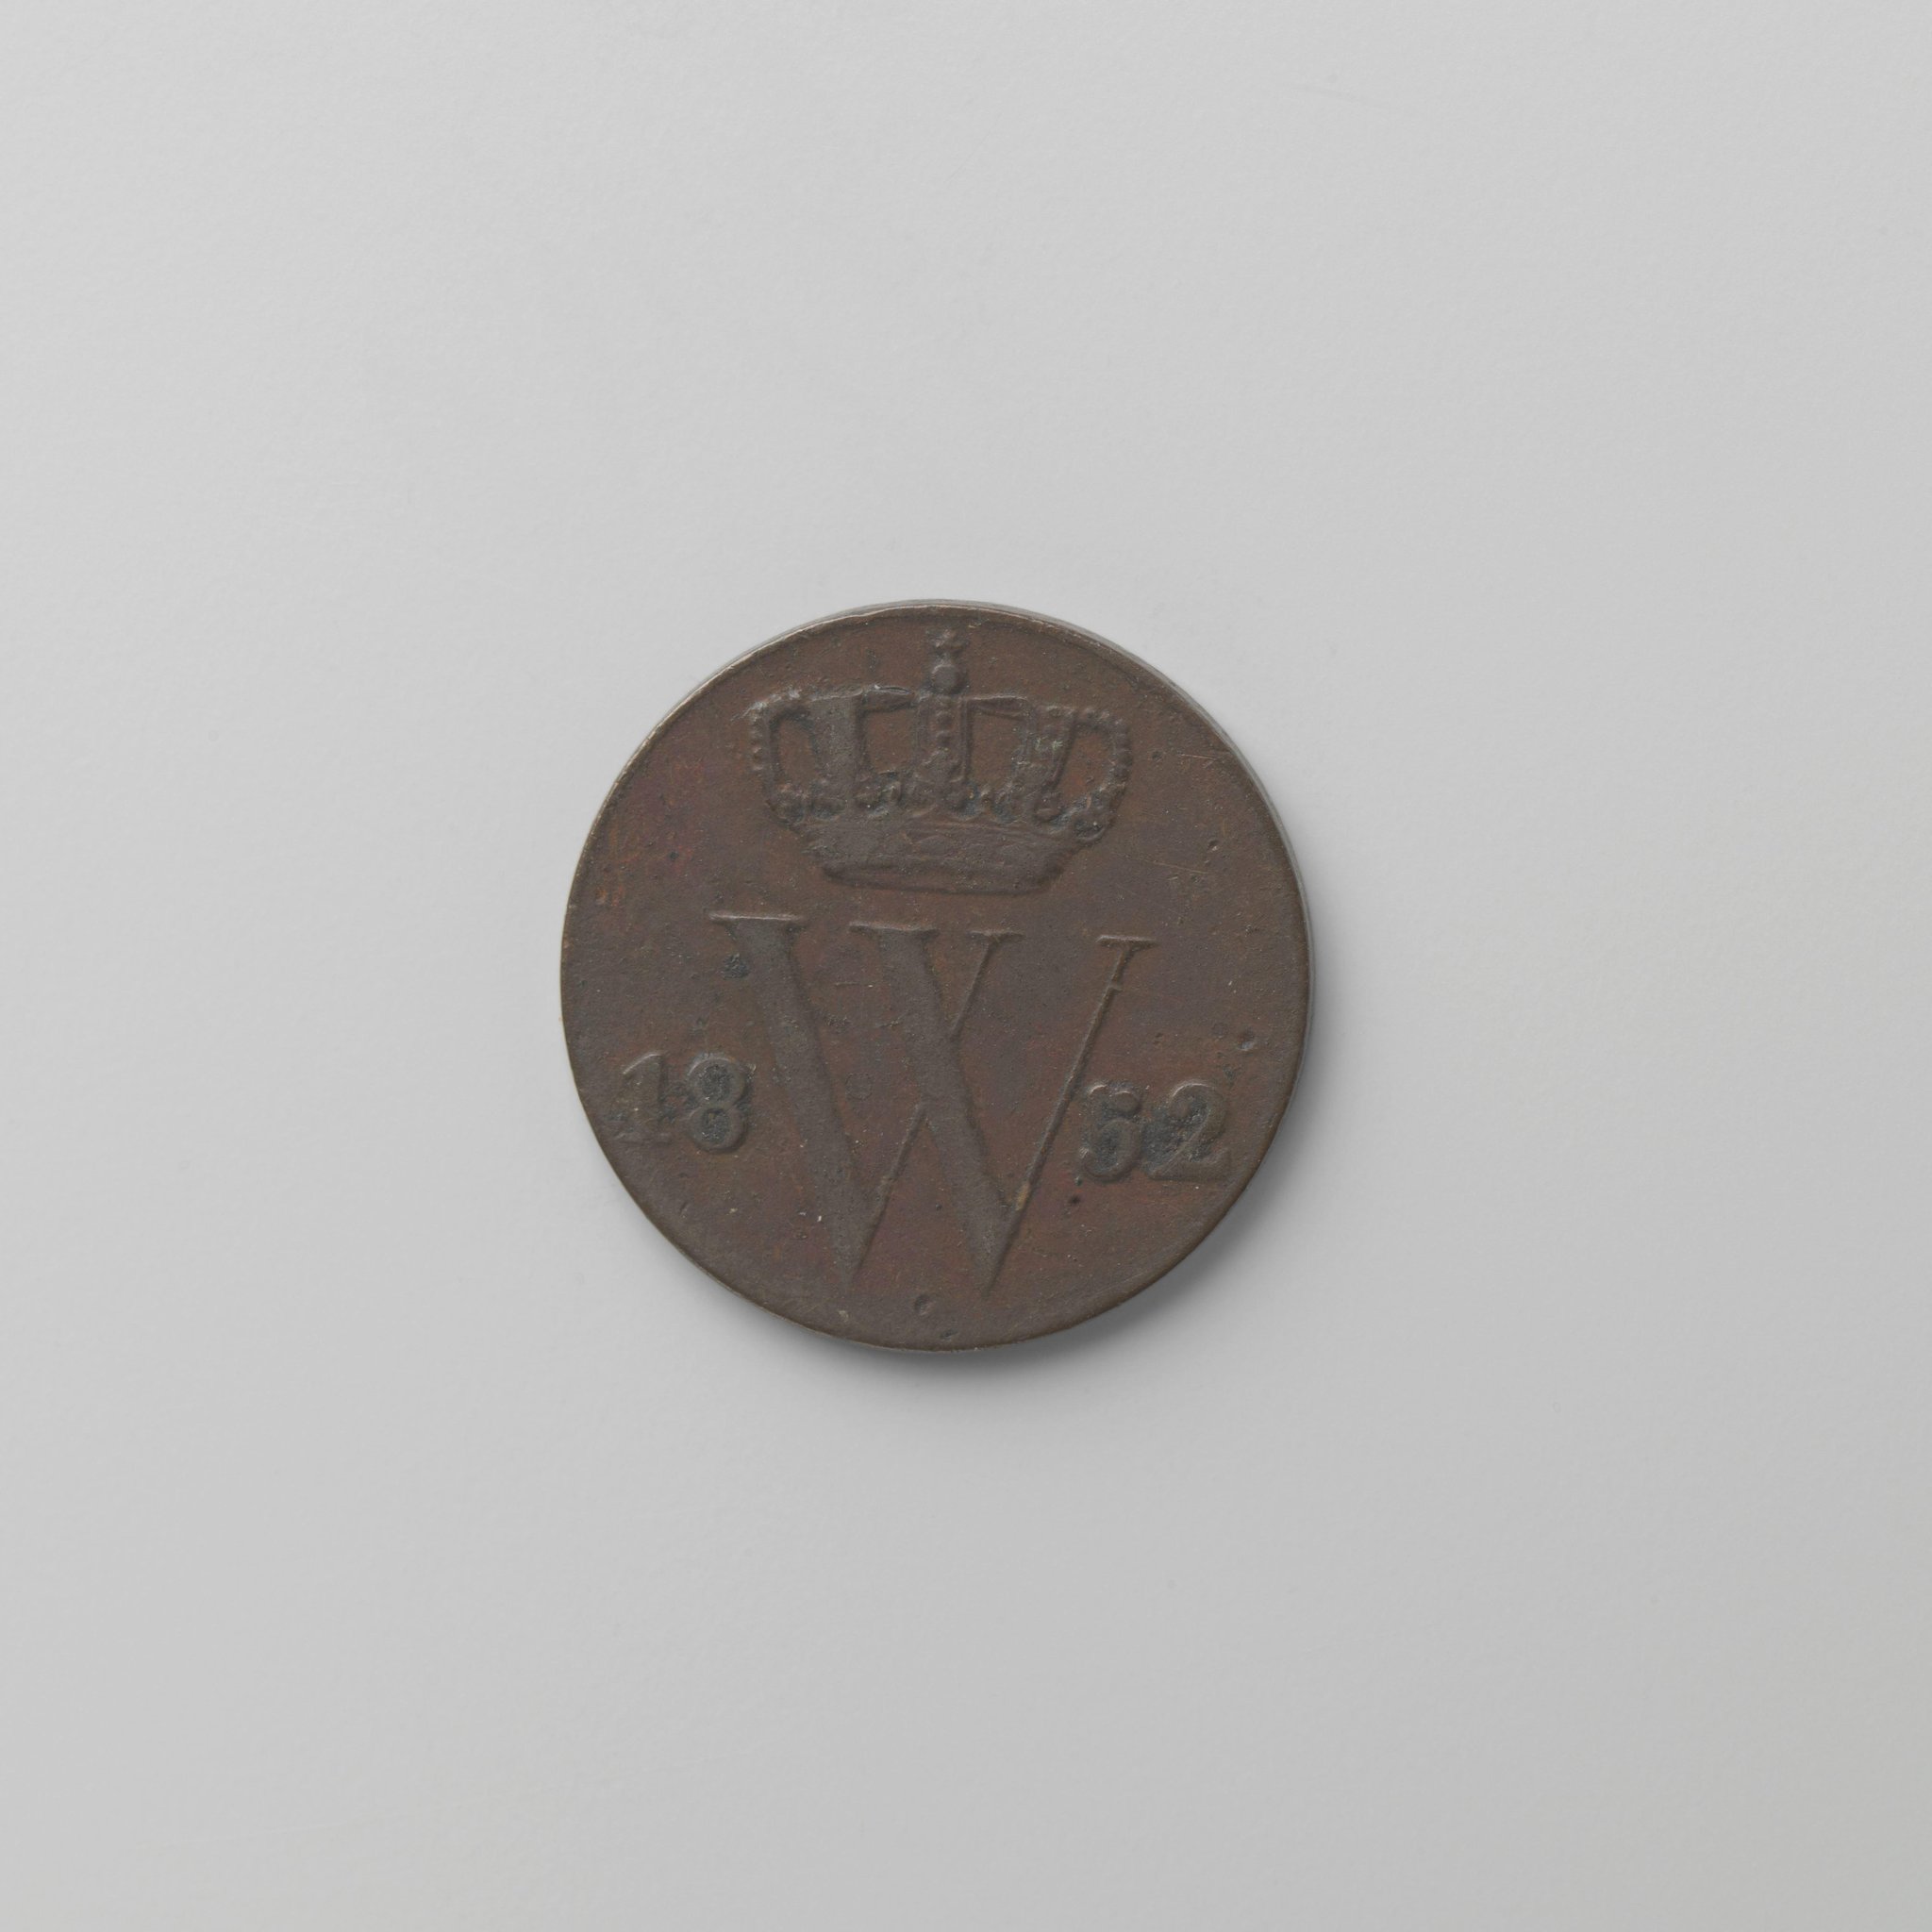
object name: coin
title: Nederlandse ½ cent, 1852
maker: willem iii (koning der nederlanden)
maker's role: koning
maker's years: 1817-1890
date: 1852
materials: copper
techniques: striking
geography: utrecht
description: Koperen munt. Voorzijde: tussen jaartal gekroonde rechte letter W. Keerzijde: tussen waarde-aanduiding ½ C. gekroond rijkswapenschild. Gladde rand.